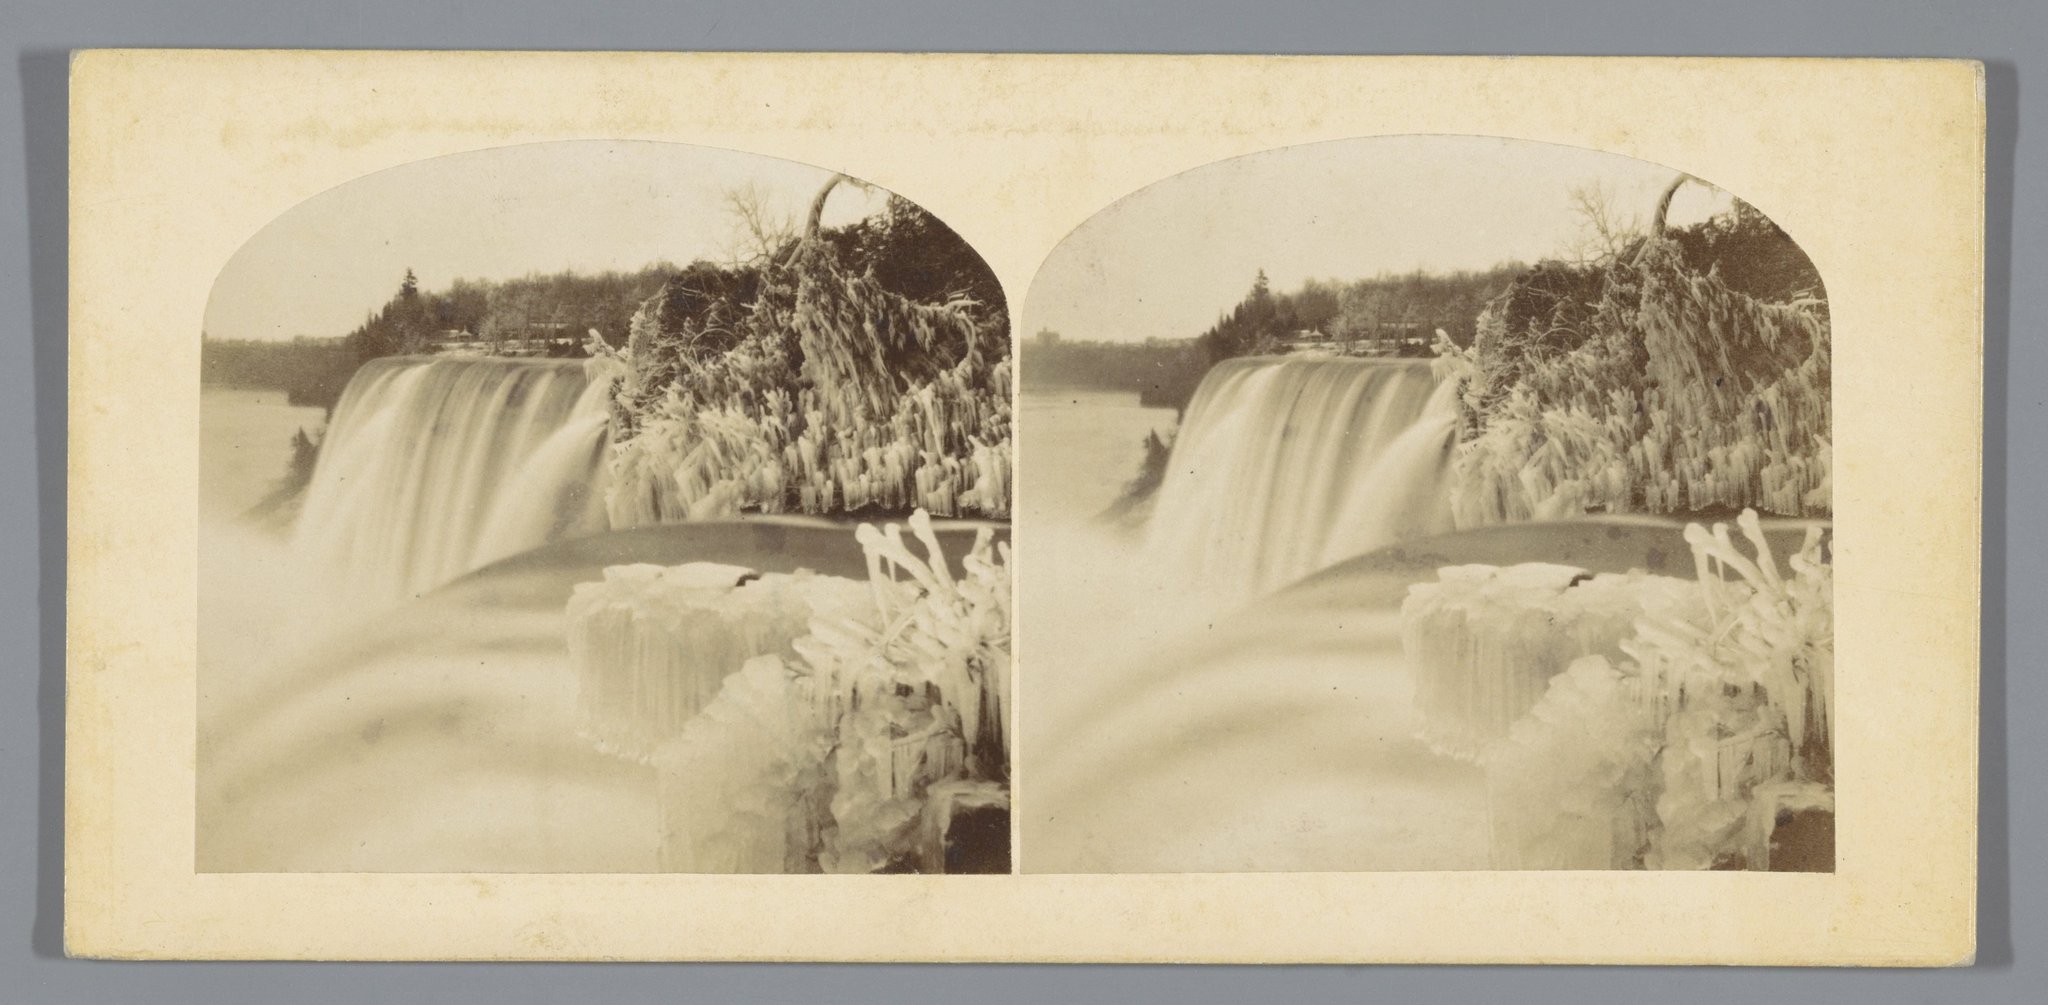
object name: stereograph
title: American Fall, Niagara, From Goat Island. - A Winter Scene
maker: william england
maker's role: fotograaf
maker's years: 1816-1896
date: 1859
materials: cardboard, paper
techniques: albumen print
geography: london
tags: waterfall, severe winters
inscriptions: : ‘At the foot (...) unalterable mien." Byron’